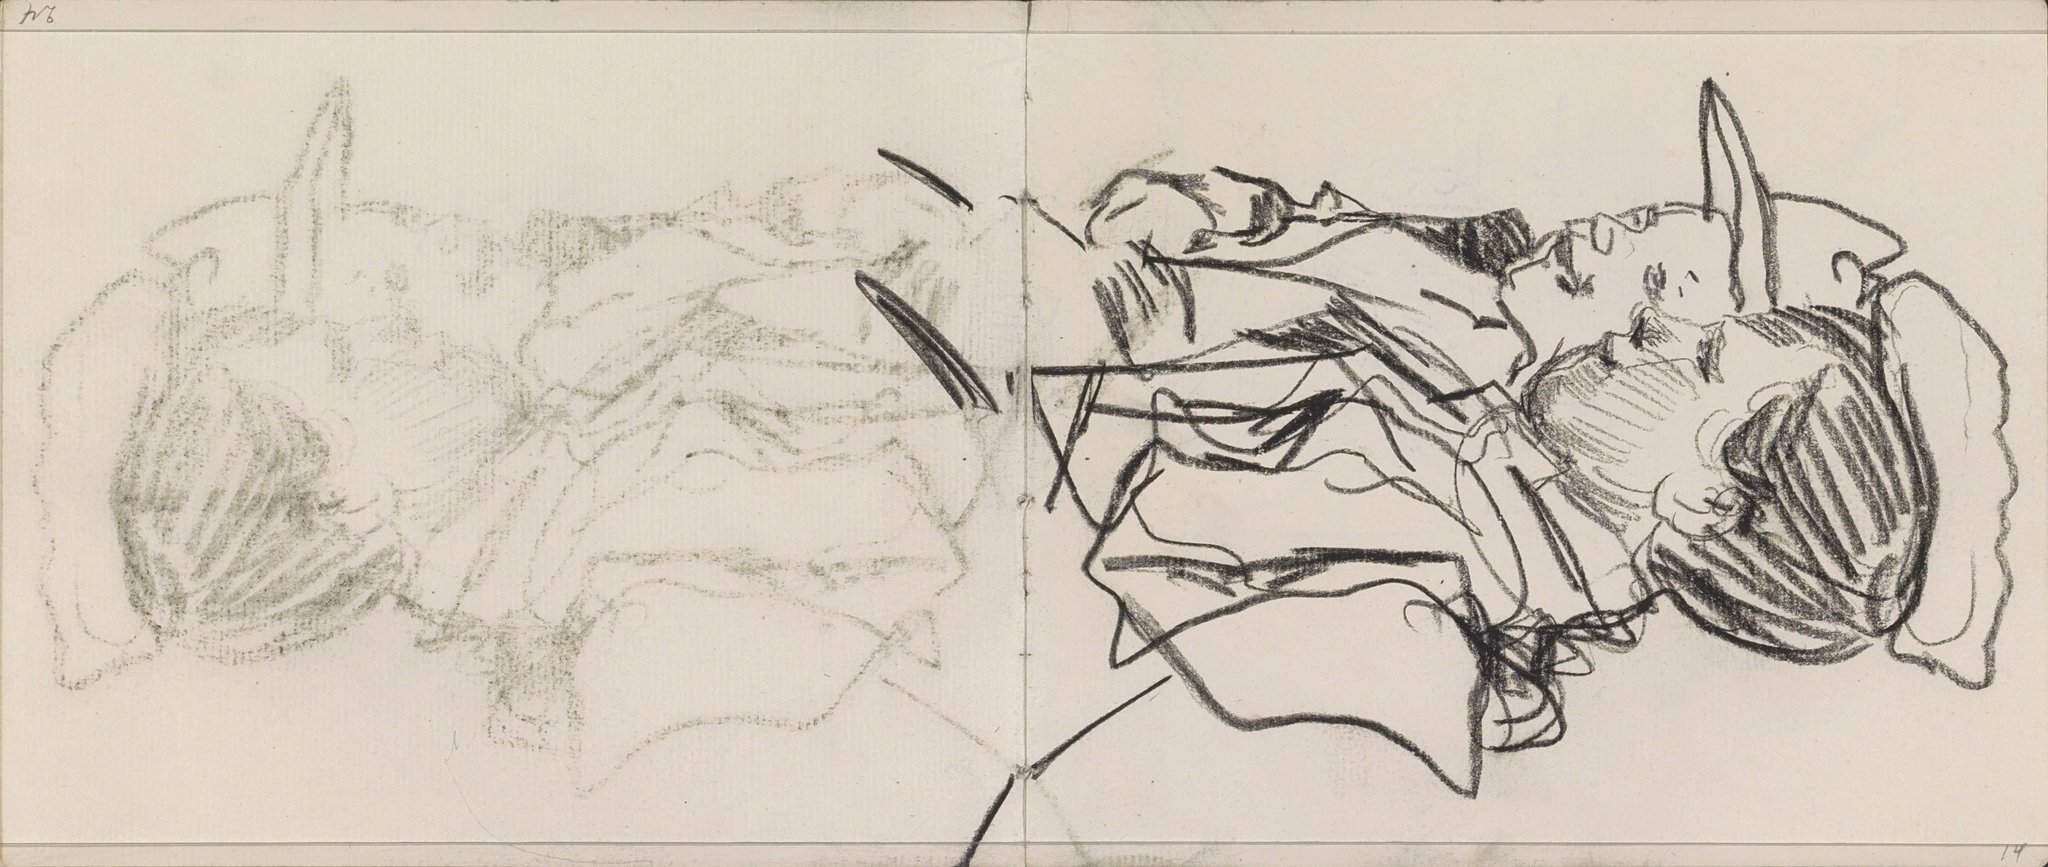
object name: sketchbook leaf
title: Twee vrouwen, mogelijk dienstmeiden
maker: isaac israels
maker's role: draughtsman, painter, print maker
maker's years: 1865-1934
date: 1886-1934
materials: chalk, paper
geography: amsterdam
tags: adult woman (+ two persons), maid ~ house personnel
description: Blad 13 verso en blad 14 recto uit schetsboek LIV met 18 bladen.